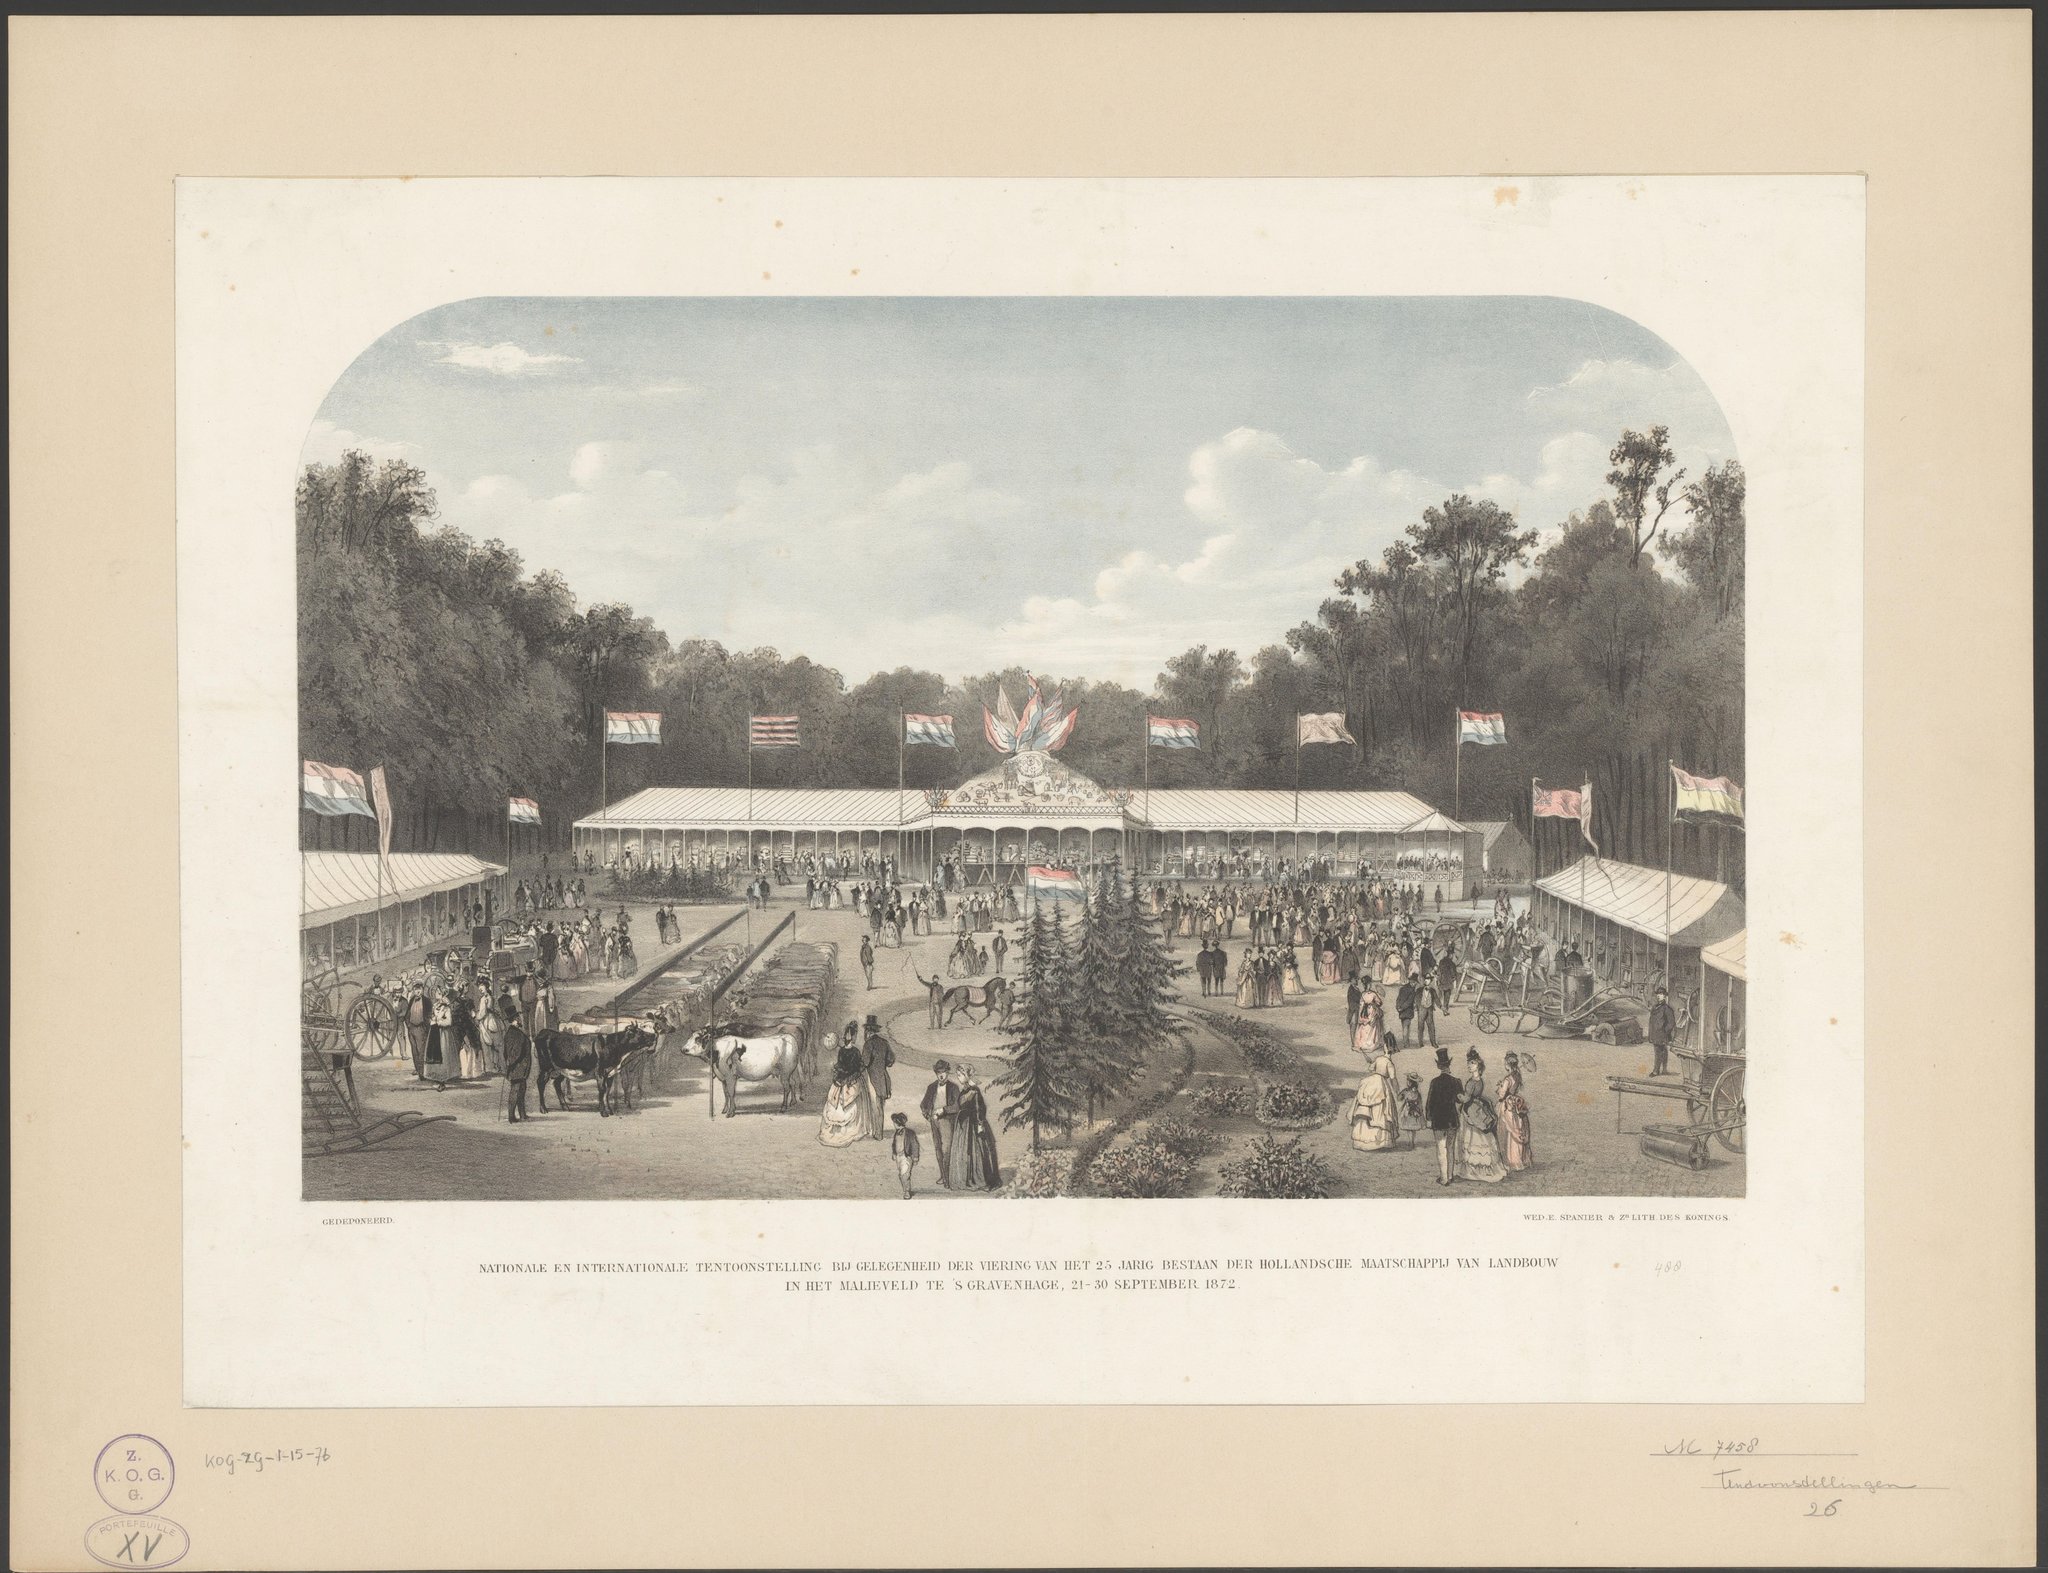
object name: print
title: Viering van het 25-jarige bestaan van de Hollandsche Maatschappij van Landbouw tijdens de Nationale en Internationale tentoonstelling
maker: Anonymous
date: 1872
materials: paper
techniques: lithograph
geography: the hague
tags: bull, cow, trade exhibition, industries fair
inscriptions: collector's mark: Lugt 1641, stamp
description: Viering van het 25-jarige bestaan van de Hollandsche Maatschappij van Landbouw tijdens de Nationale en Internationale tentoonstelling op het Malieveld in Den Haag tussen 21 en 30 september 1872. Onderwerpsrubrieken binnen de Atlas Zeden en Gewoonten: Handel, nijverheid en verkeer, Tentoonstellingen.